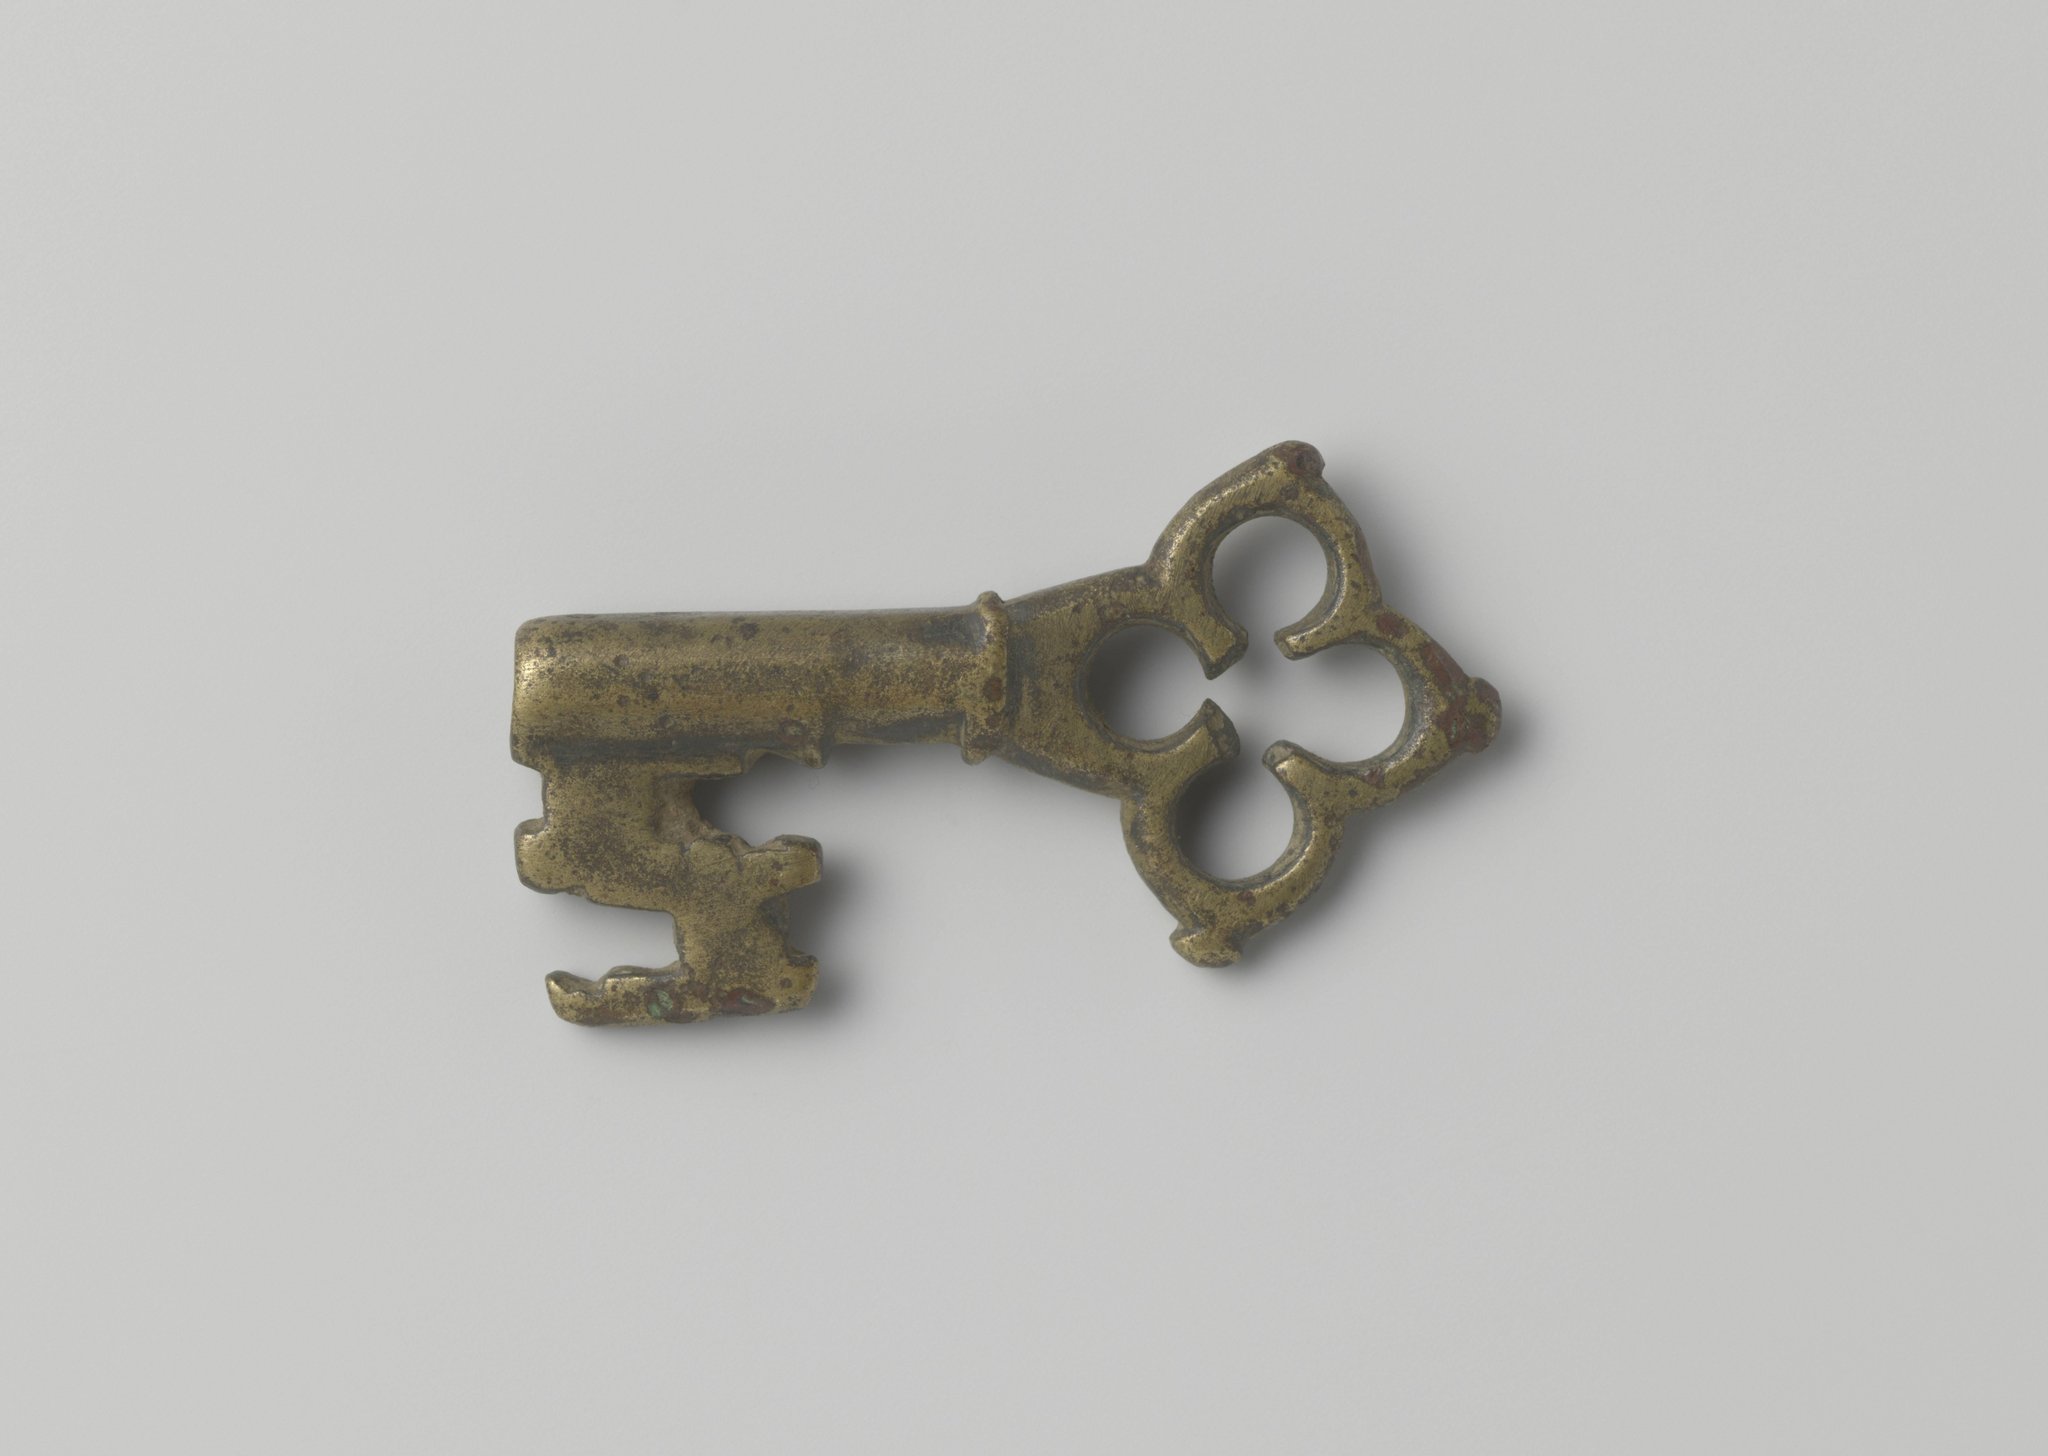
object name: pipe key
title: Pijpsleutel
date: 1300-1500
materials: bronze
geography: france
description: Bronzen pijpsleutel, gelobde ring met vierpasvormige opening; baard van boven en onder ingesneden.